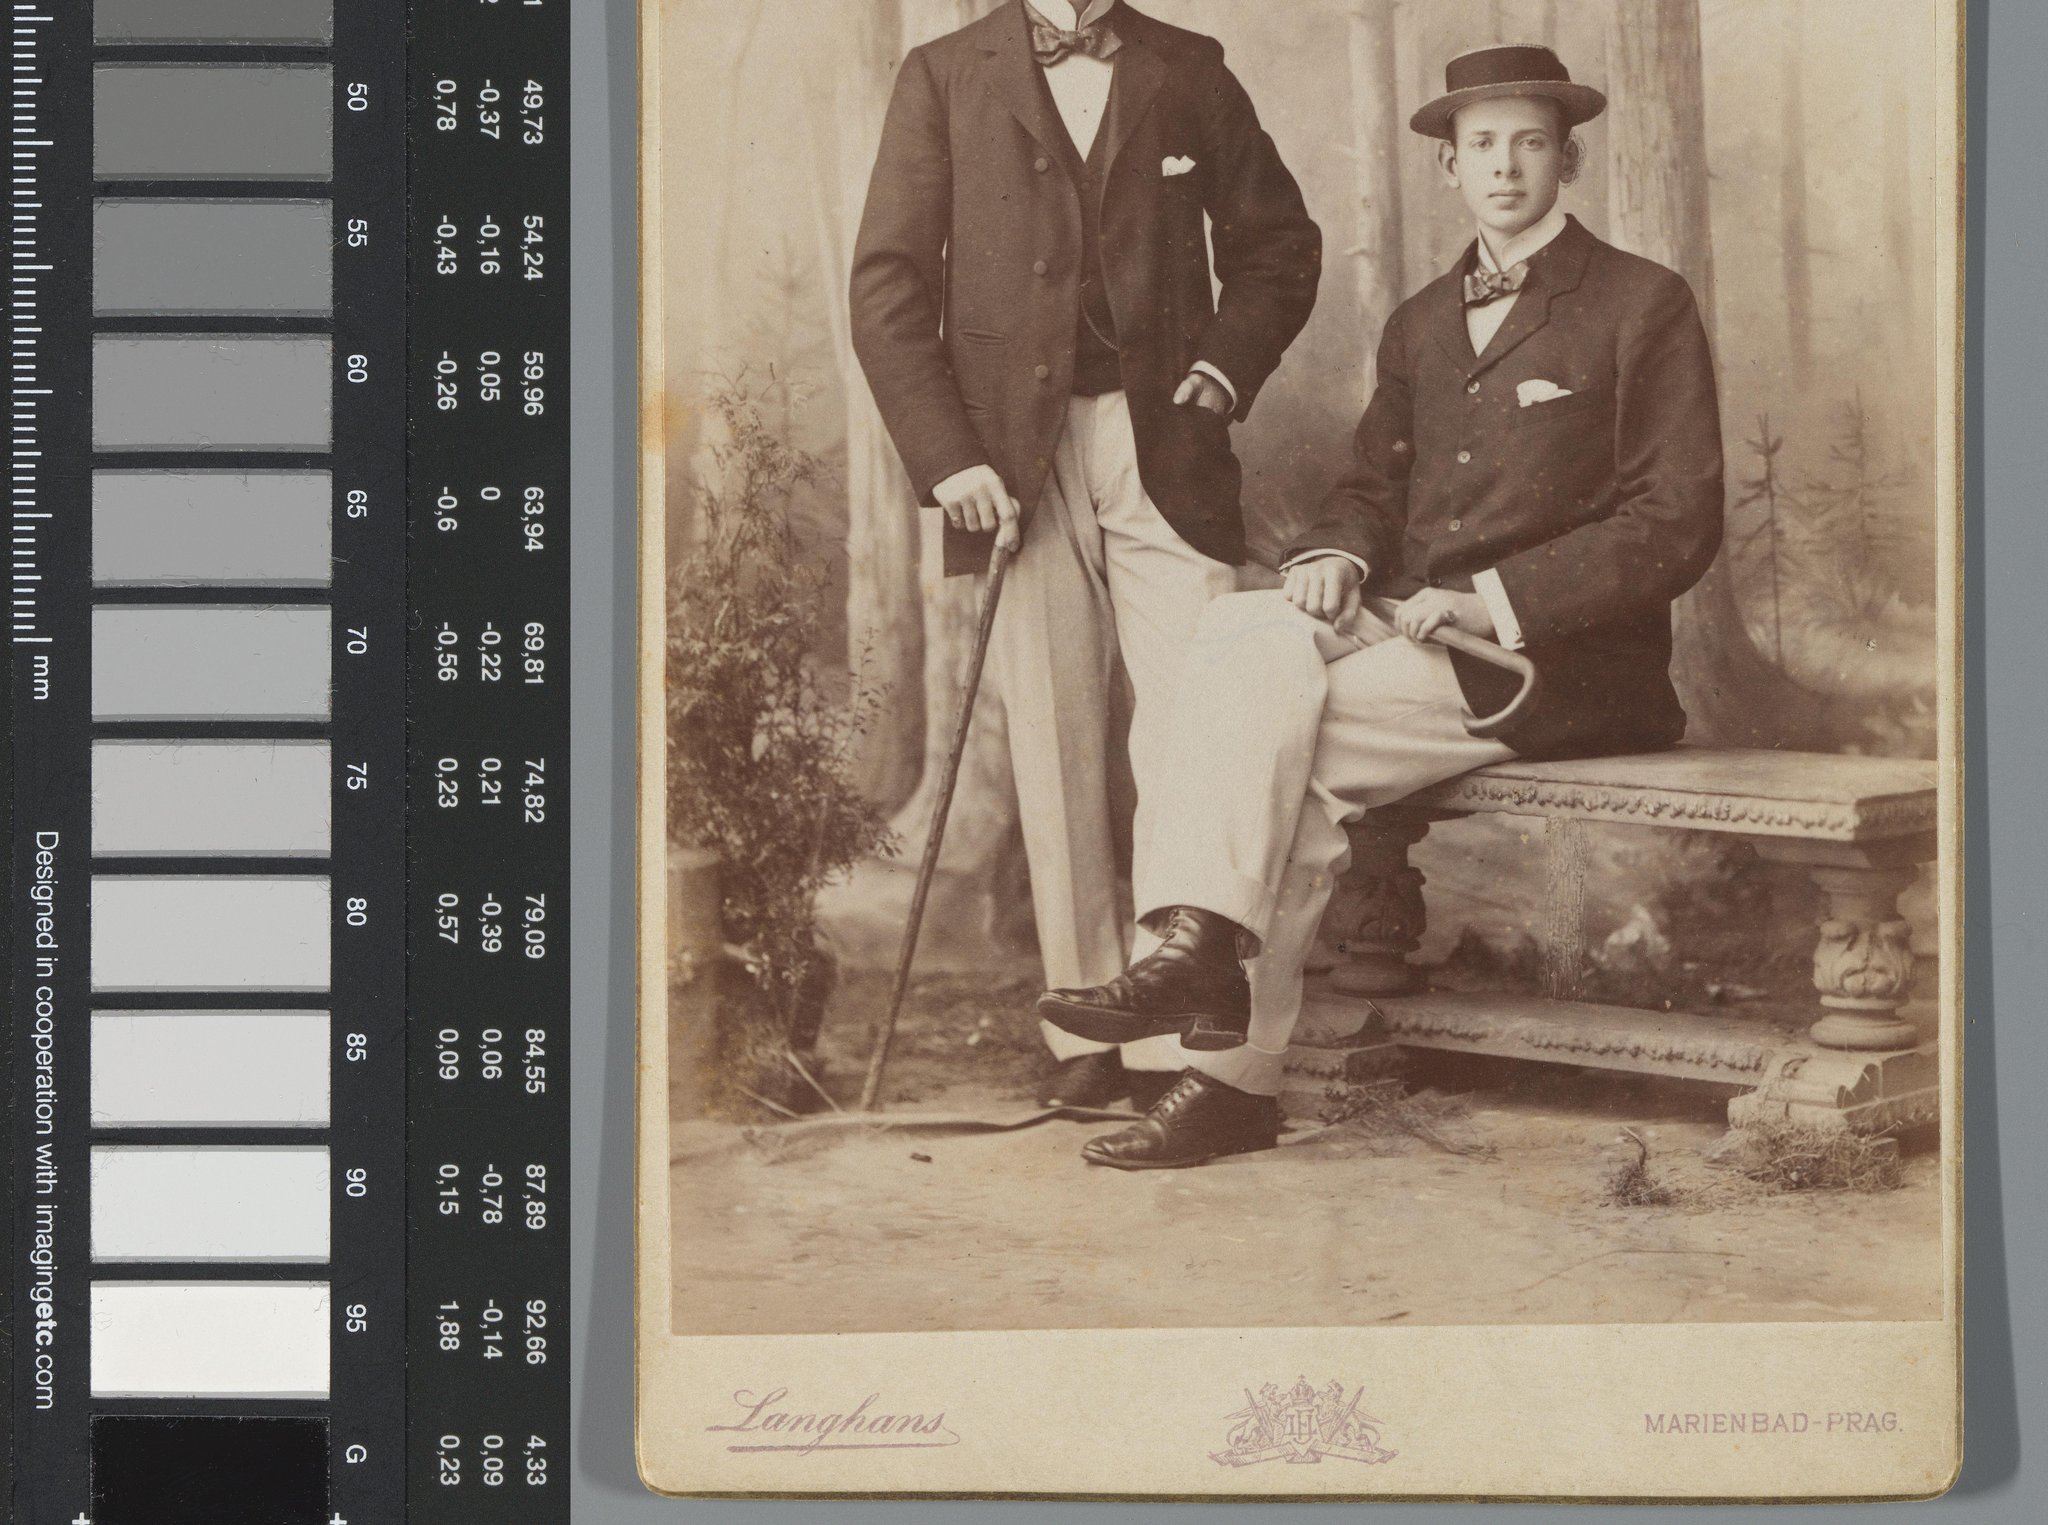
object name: cabinet photograph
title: Portret van hendrik Herman en Karel Frederik van den Berg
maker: jan f. langhans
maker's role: chemicus, fotograaf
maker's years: 1851-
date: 1900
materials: cardboard, photographic support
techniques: albumen print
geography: europe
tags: batavia, amsterdam, hendrik herman van den berg, karel frederik van den berg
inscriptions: name: ‘Langhans MARIENBAD-PRAG.’, number: ‘7382’